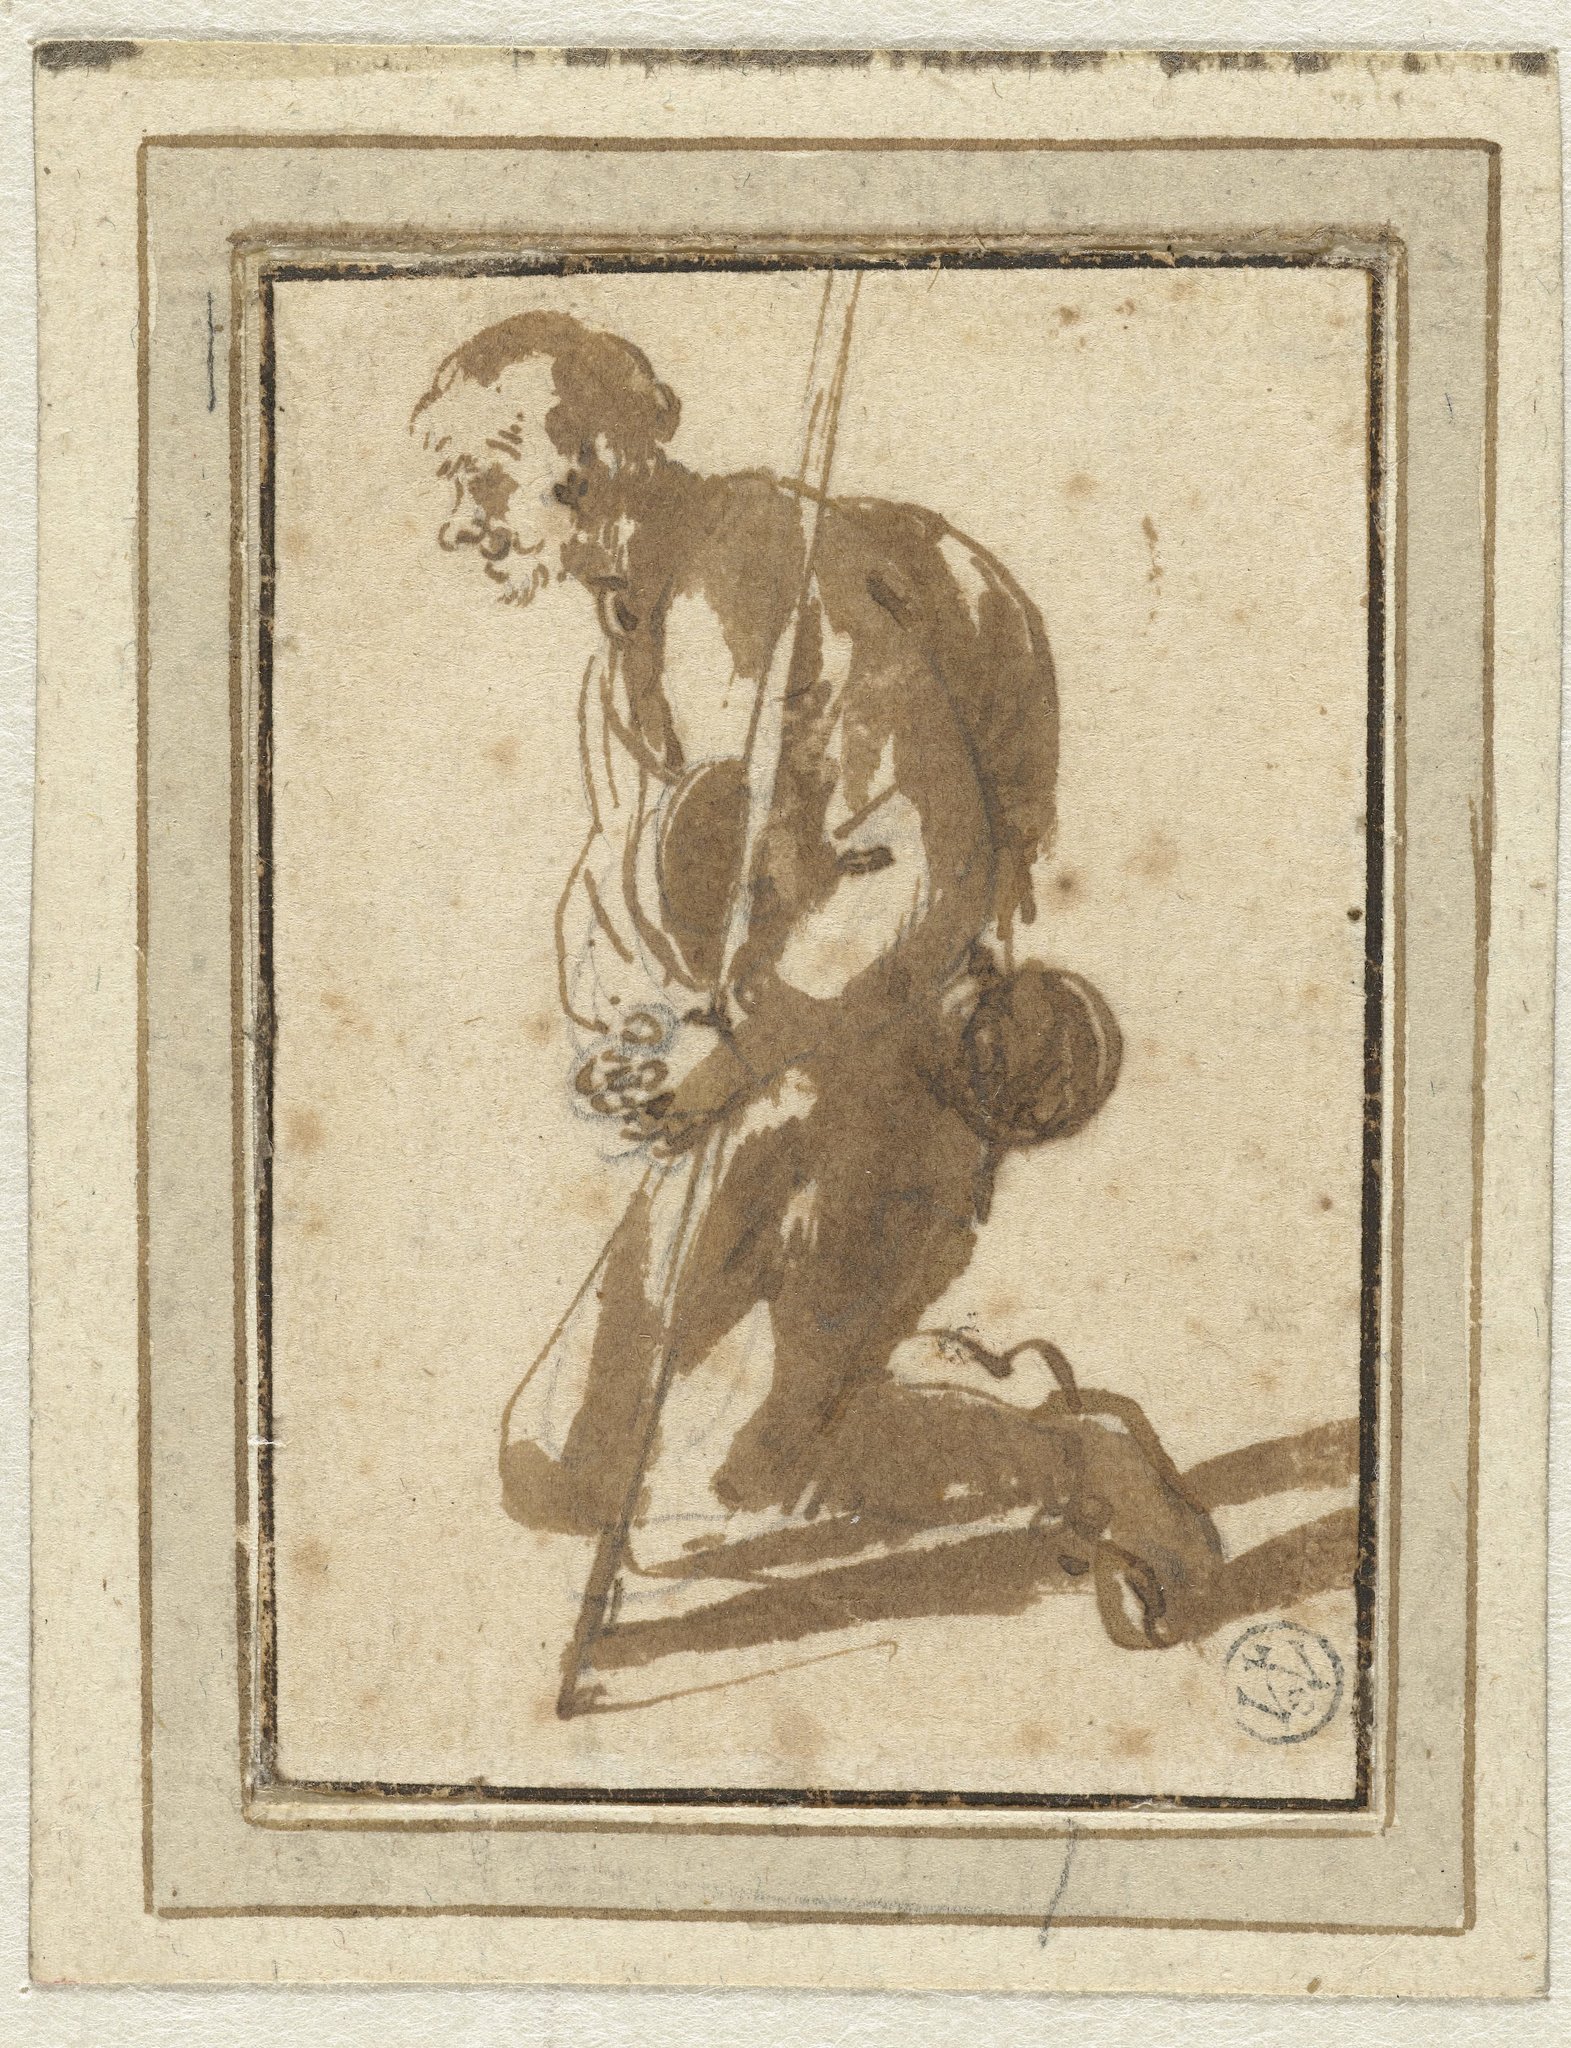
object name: drawing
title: Knielende herder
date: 1644-1649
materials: ink, paper, pencil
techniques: brush, pen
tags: herding, herdsman, herdswoman, shepherd, shepherdess, cowherd, etc., kneeling on both knees